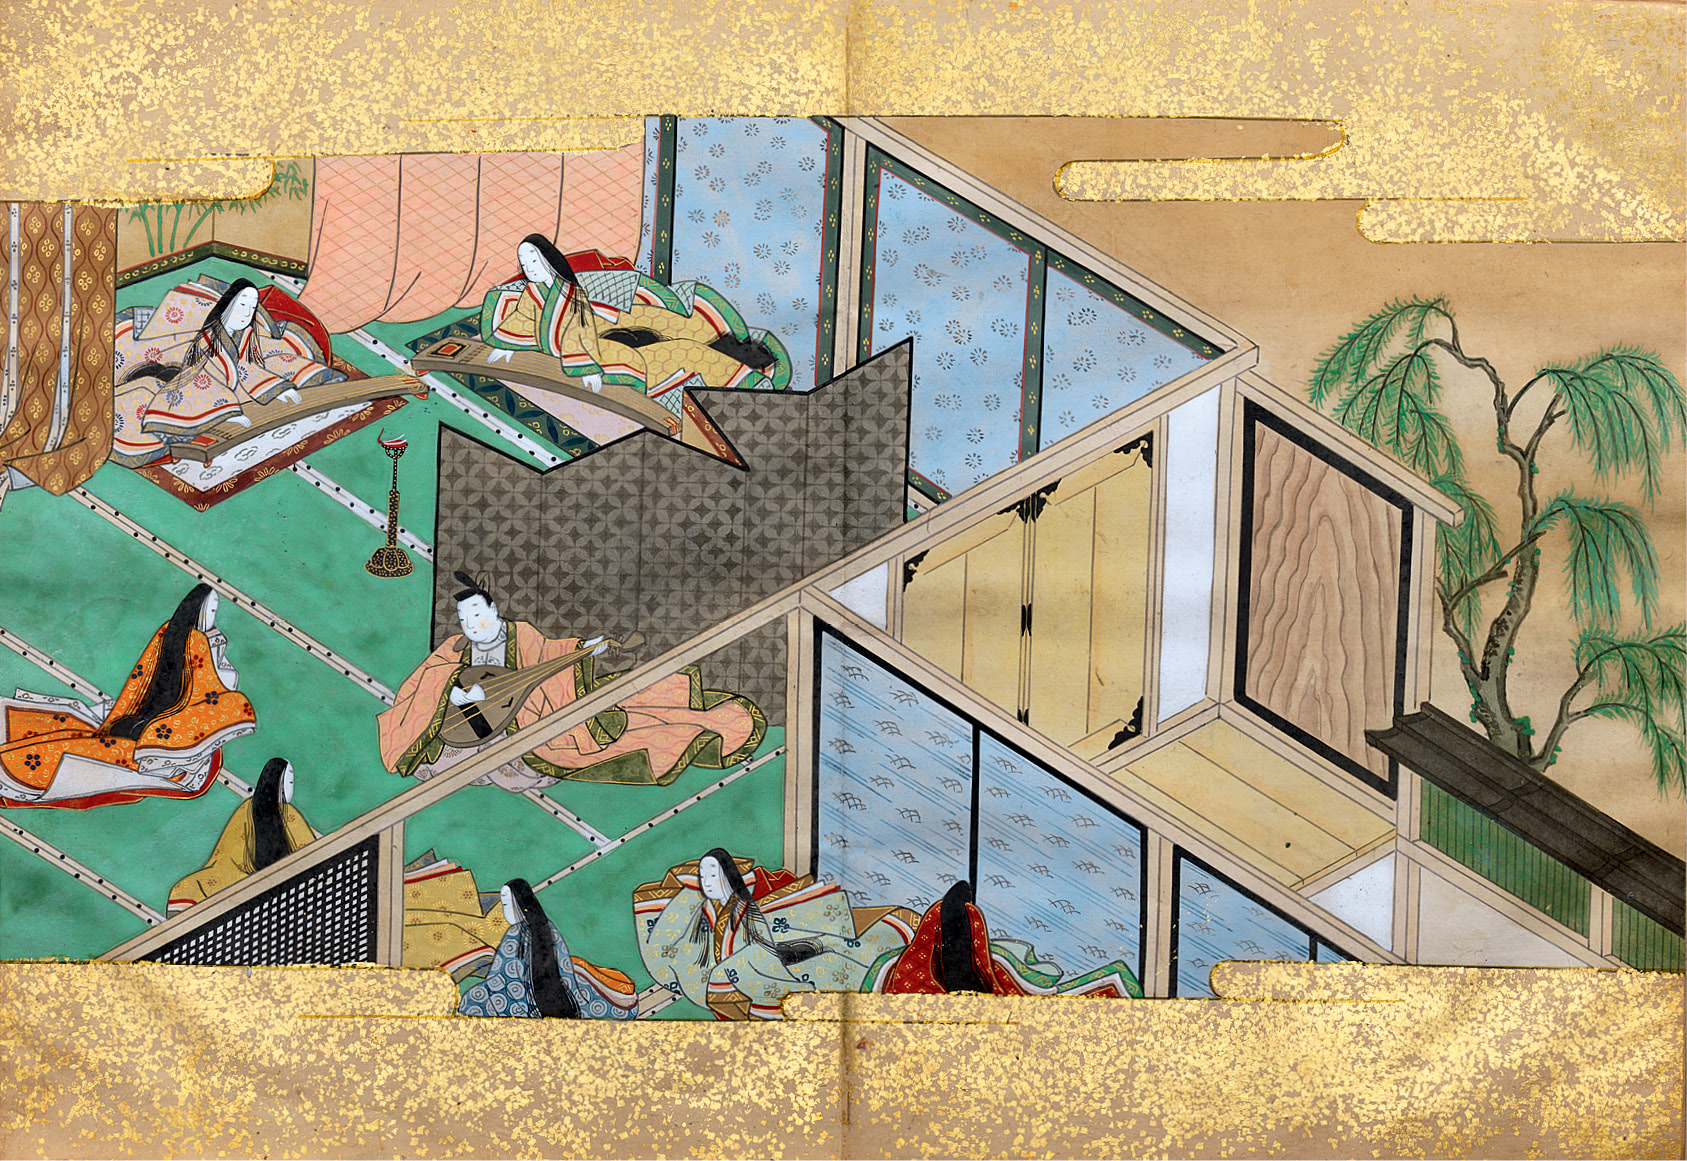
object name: book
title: Tale of the Nun Akizuki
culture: japanese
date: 1601-1700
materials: gold, ink, paper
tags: musical instruments,men,women,screens